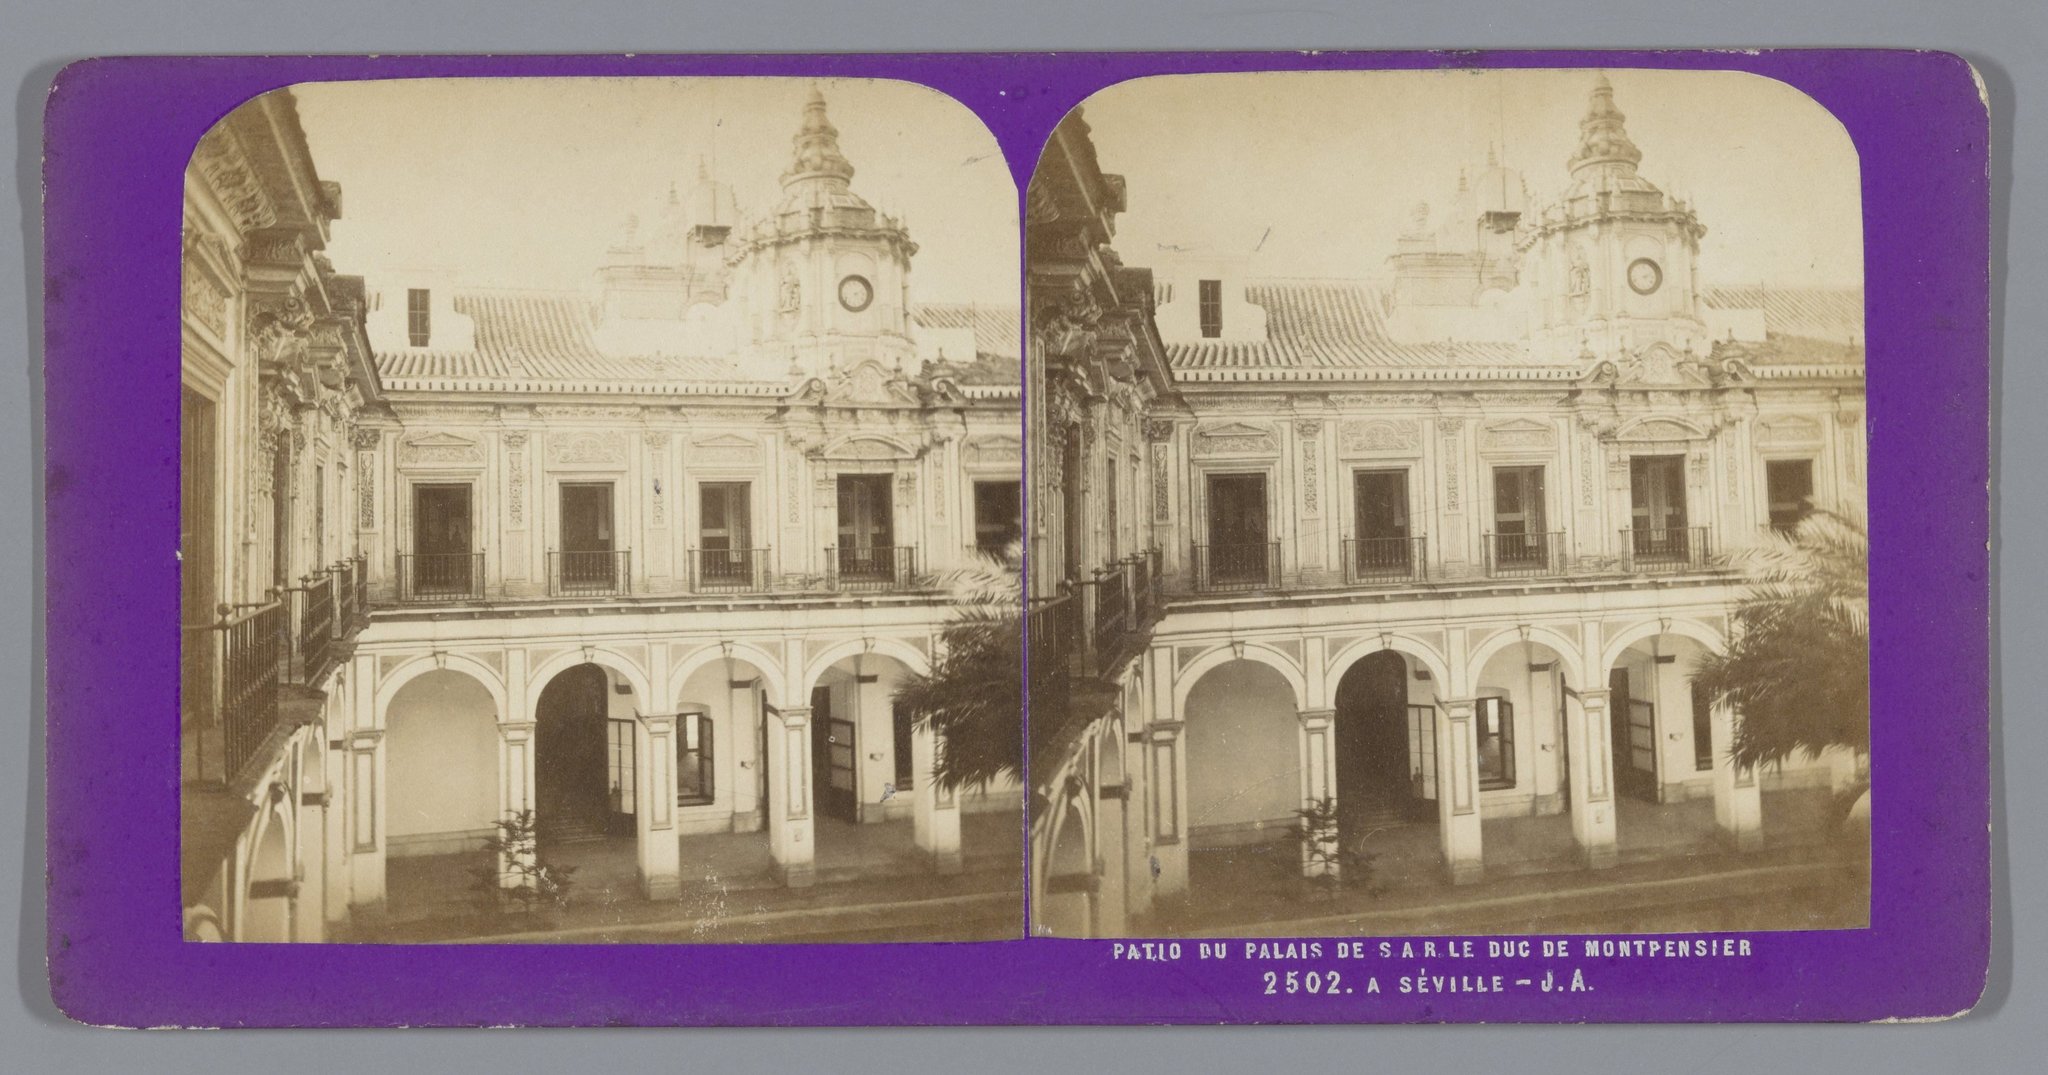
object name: stereograph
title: Patio du Palais de S.A.R. le Duc de Montpensier a Séville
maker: jean andrieu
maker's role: fotograaf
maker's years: 1816-1872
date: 1862-1876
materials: cardboard, photographic support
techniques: albumen print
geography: sevilla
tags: palace, courtyard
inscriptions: number: ‘2502.’